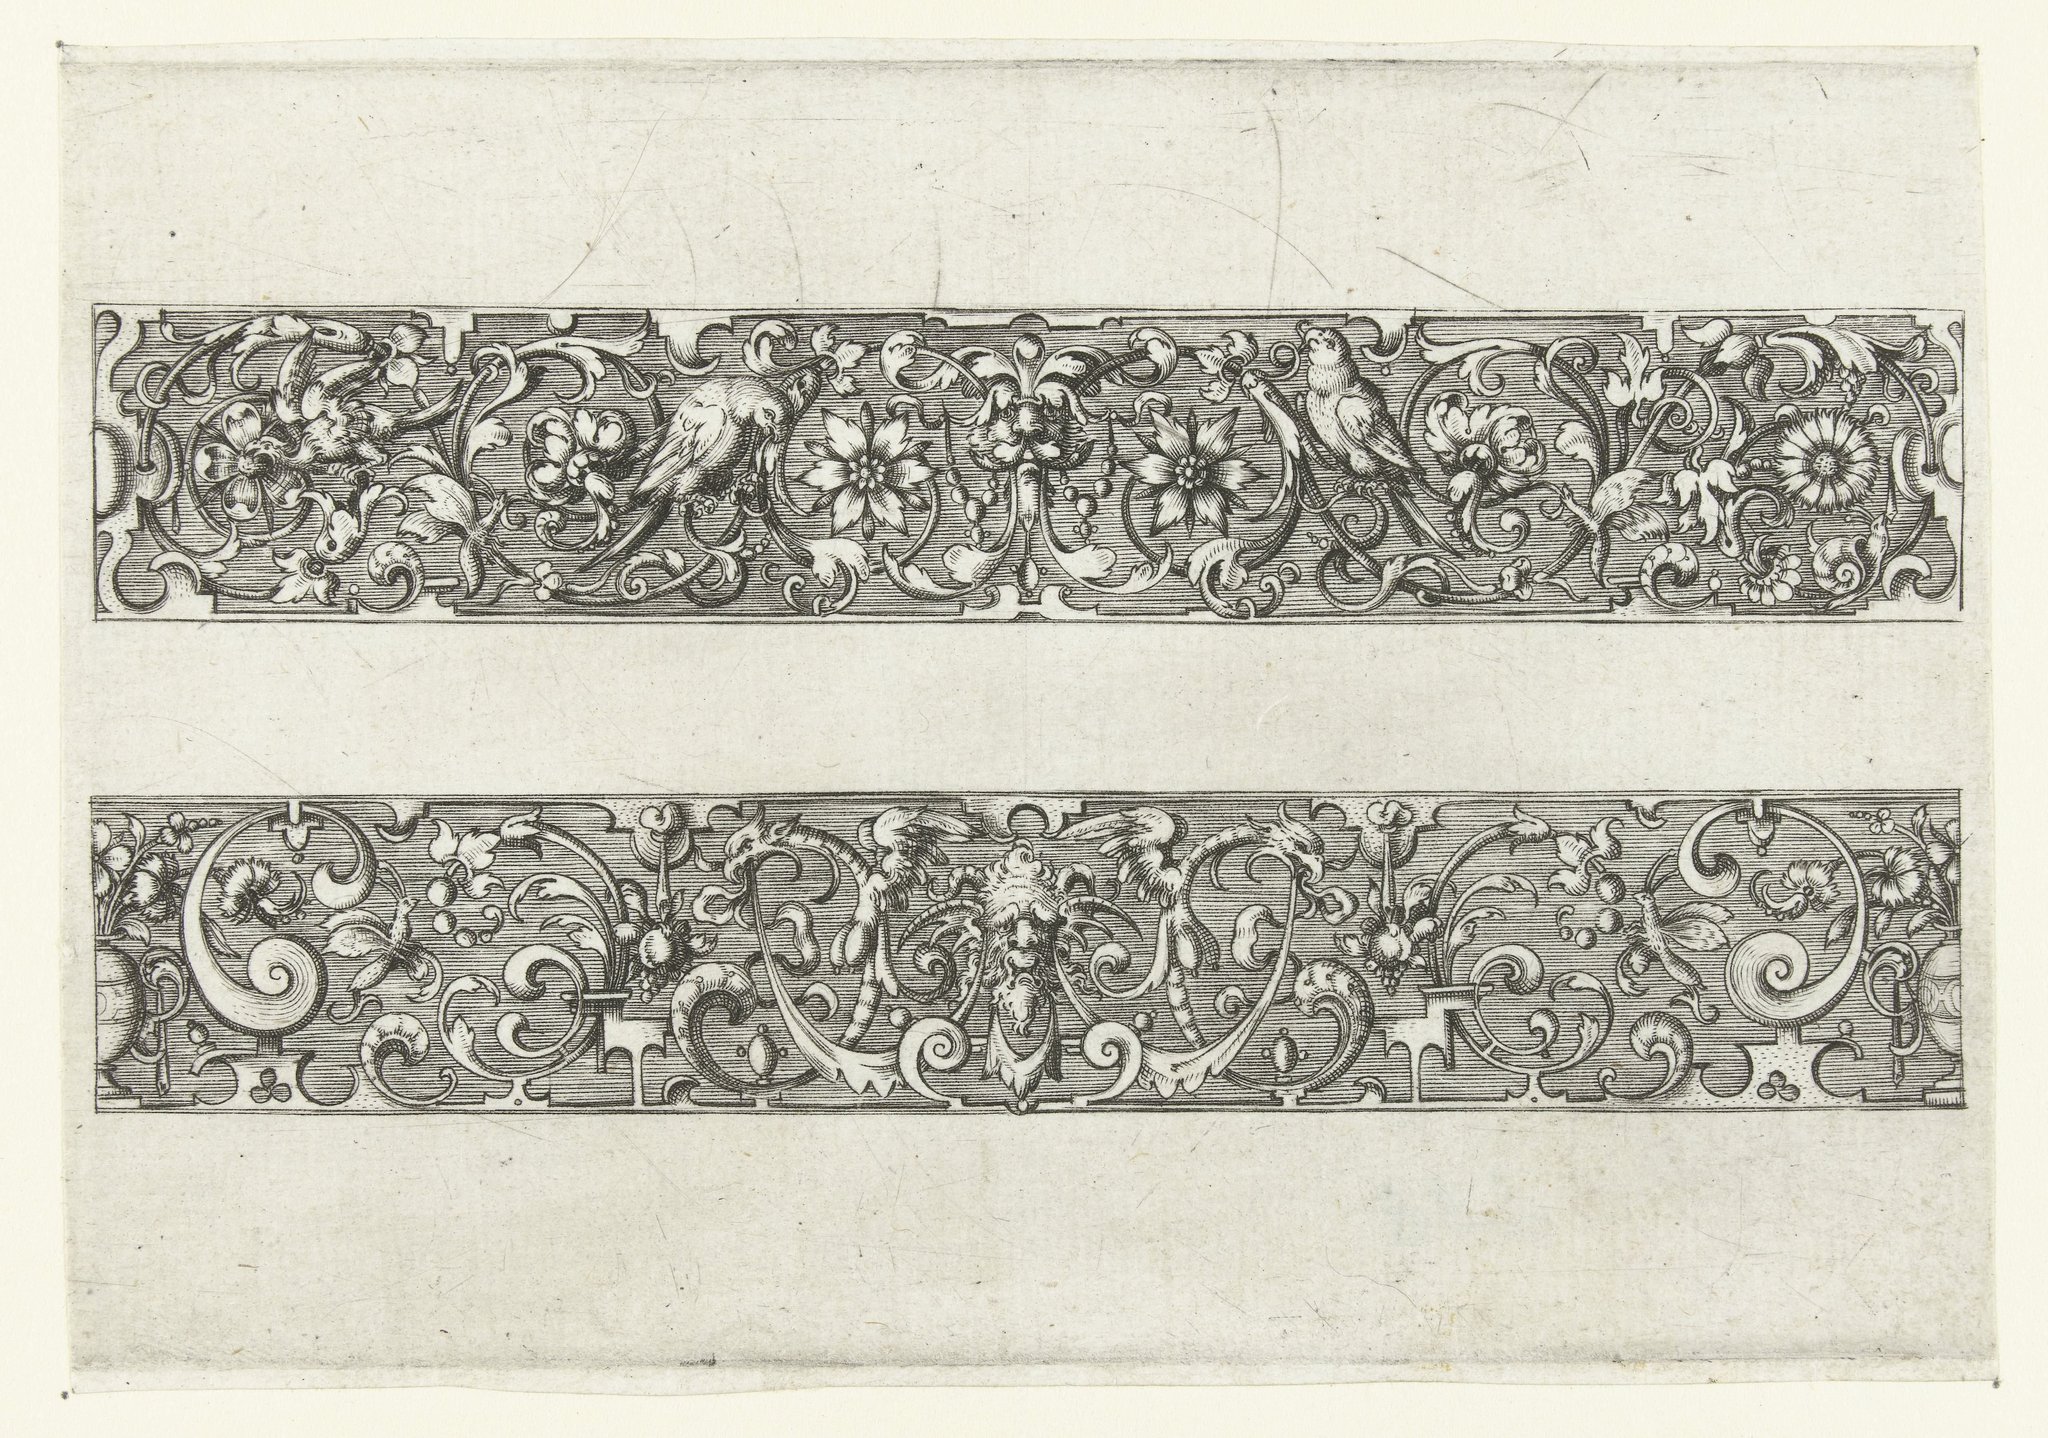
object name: ornament print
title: Twee friezen met bladranken en bloemen op één blad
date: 1571-1639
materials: paper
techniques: engraving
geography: germany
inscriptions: collector's mark: Lugt 240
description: In het midden van het bovenste fries hangt een mascaron tussen twee papegaaien. In het midden van het onderste fries hangt een mascaron tussen twee fantastische vogels. Aan beide uiteinden van het fries is de helft van een vaas met bloemen zichtbaar.